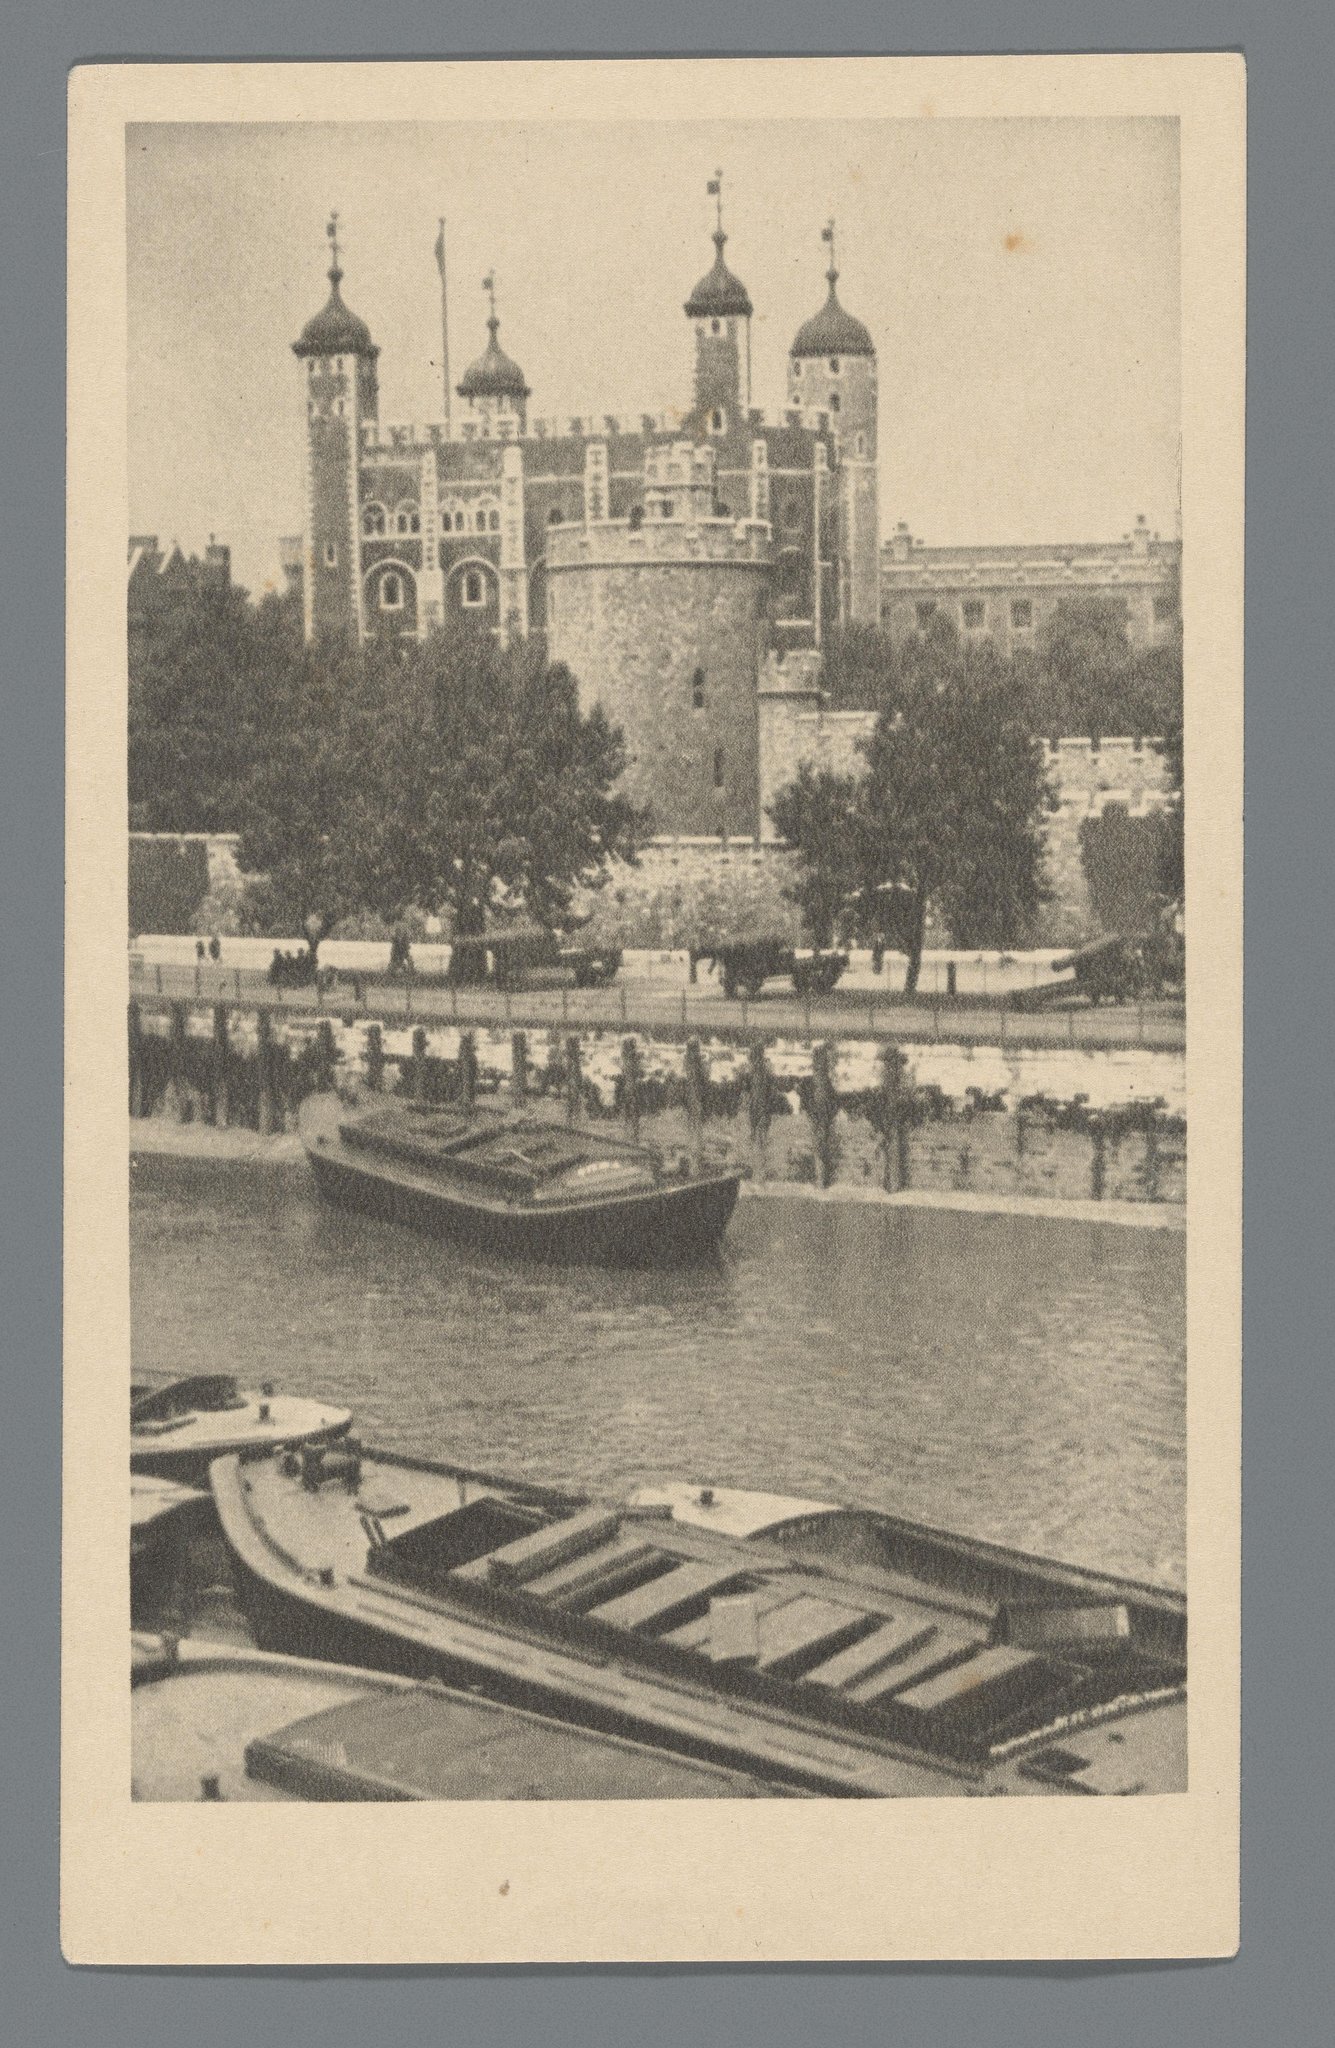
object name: photomechanical print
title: Gezicht op de Tower of London aan de Theems met boten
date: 1914-2024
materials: cardboard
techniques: photoaquatint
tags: castle, river, tow-boat, towing-barge